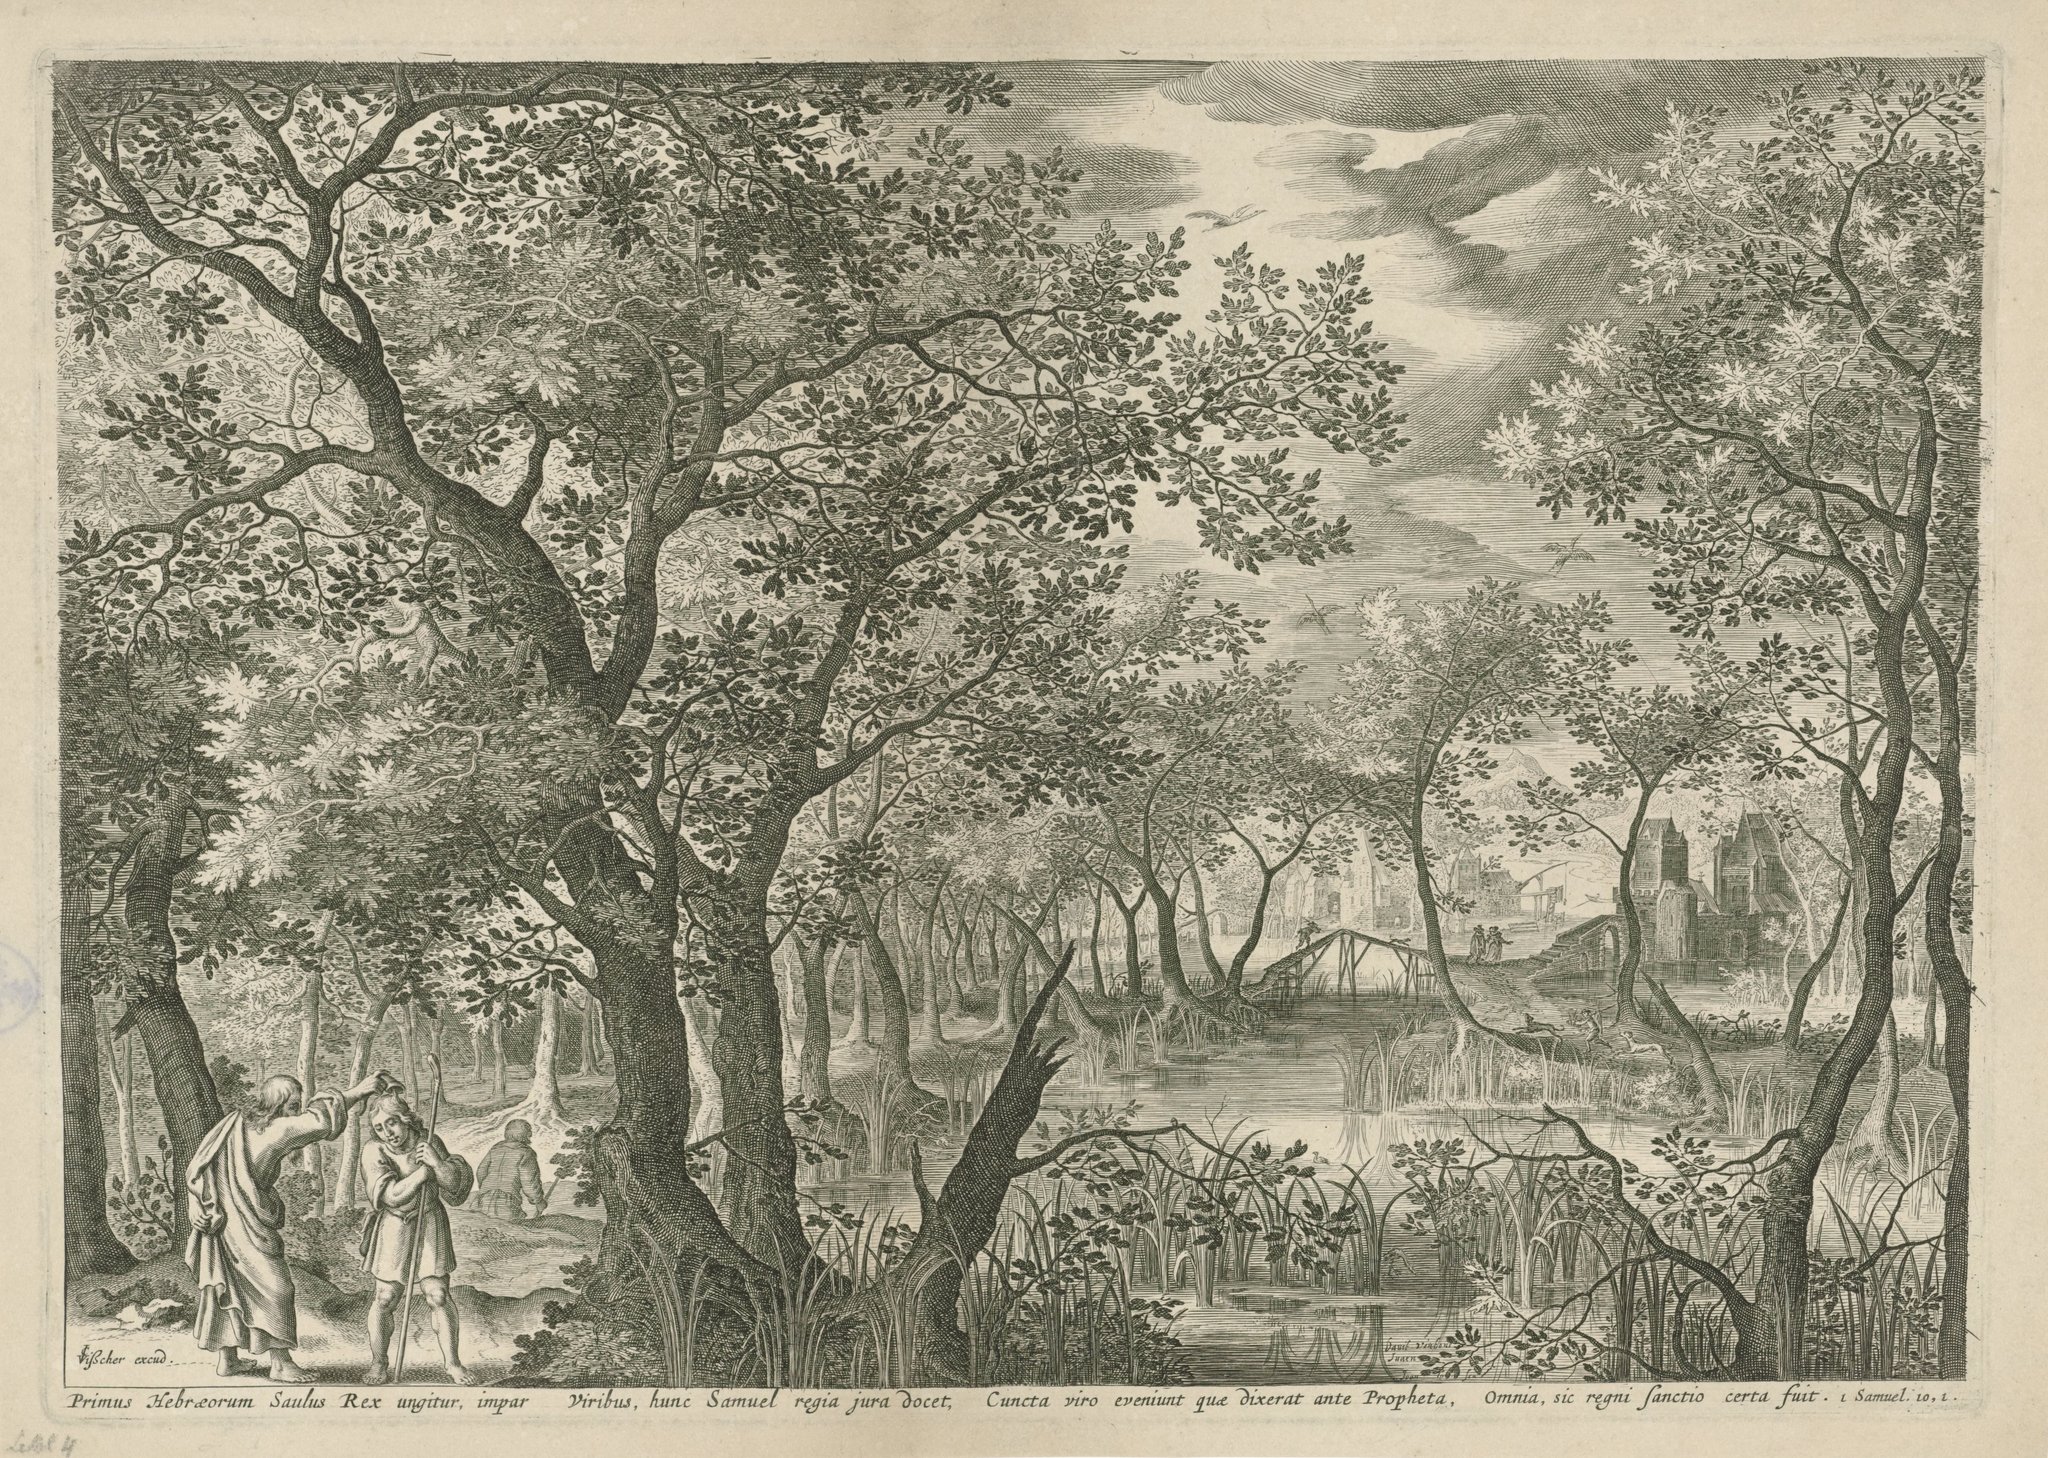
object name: print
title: Landschap met Saul door Samuël tot koning gezalfd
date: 1601-1652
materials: paper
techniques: engraving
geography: amsterdam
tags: landscapes with waters, waterscapes, seascapes (in the temperate zone), the anointment of saul by samuel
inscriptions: collector's mark: Lugt 2228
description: Waterrijk landschap waarin Saul door Samuël tot koning wordt gezalfd. Samuël leegt een kruikje olie boven het hoofd van Saul. In de marge een onderschrift in Latijn, met bijbelverwijzing naar 1 Sam. 10:1.